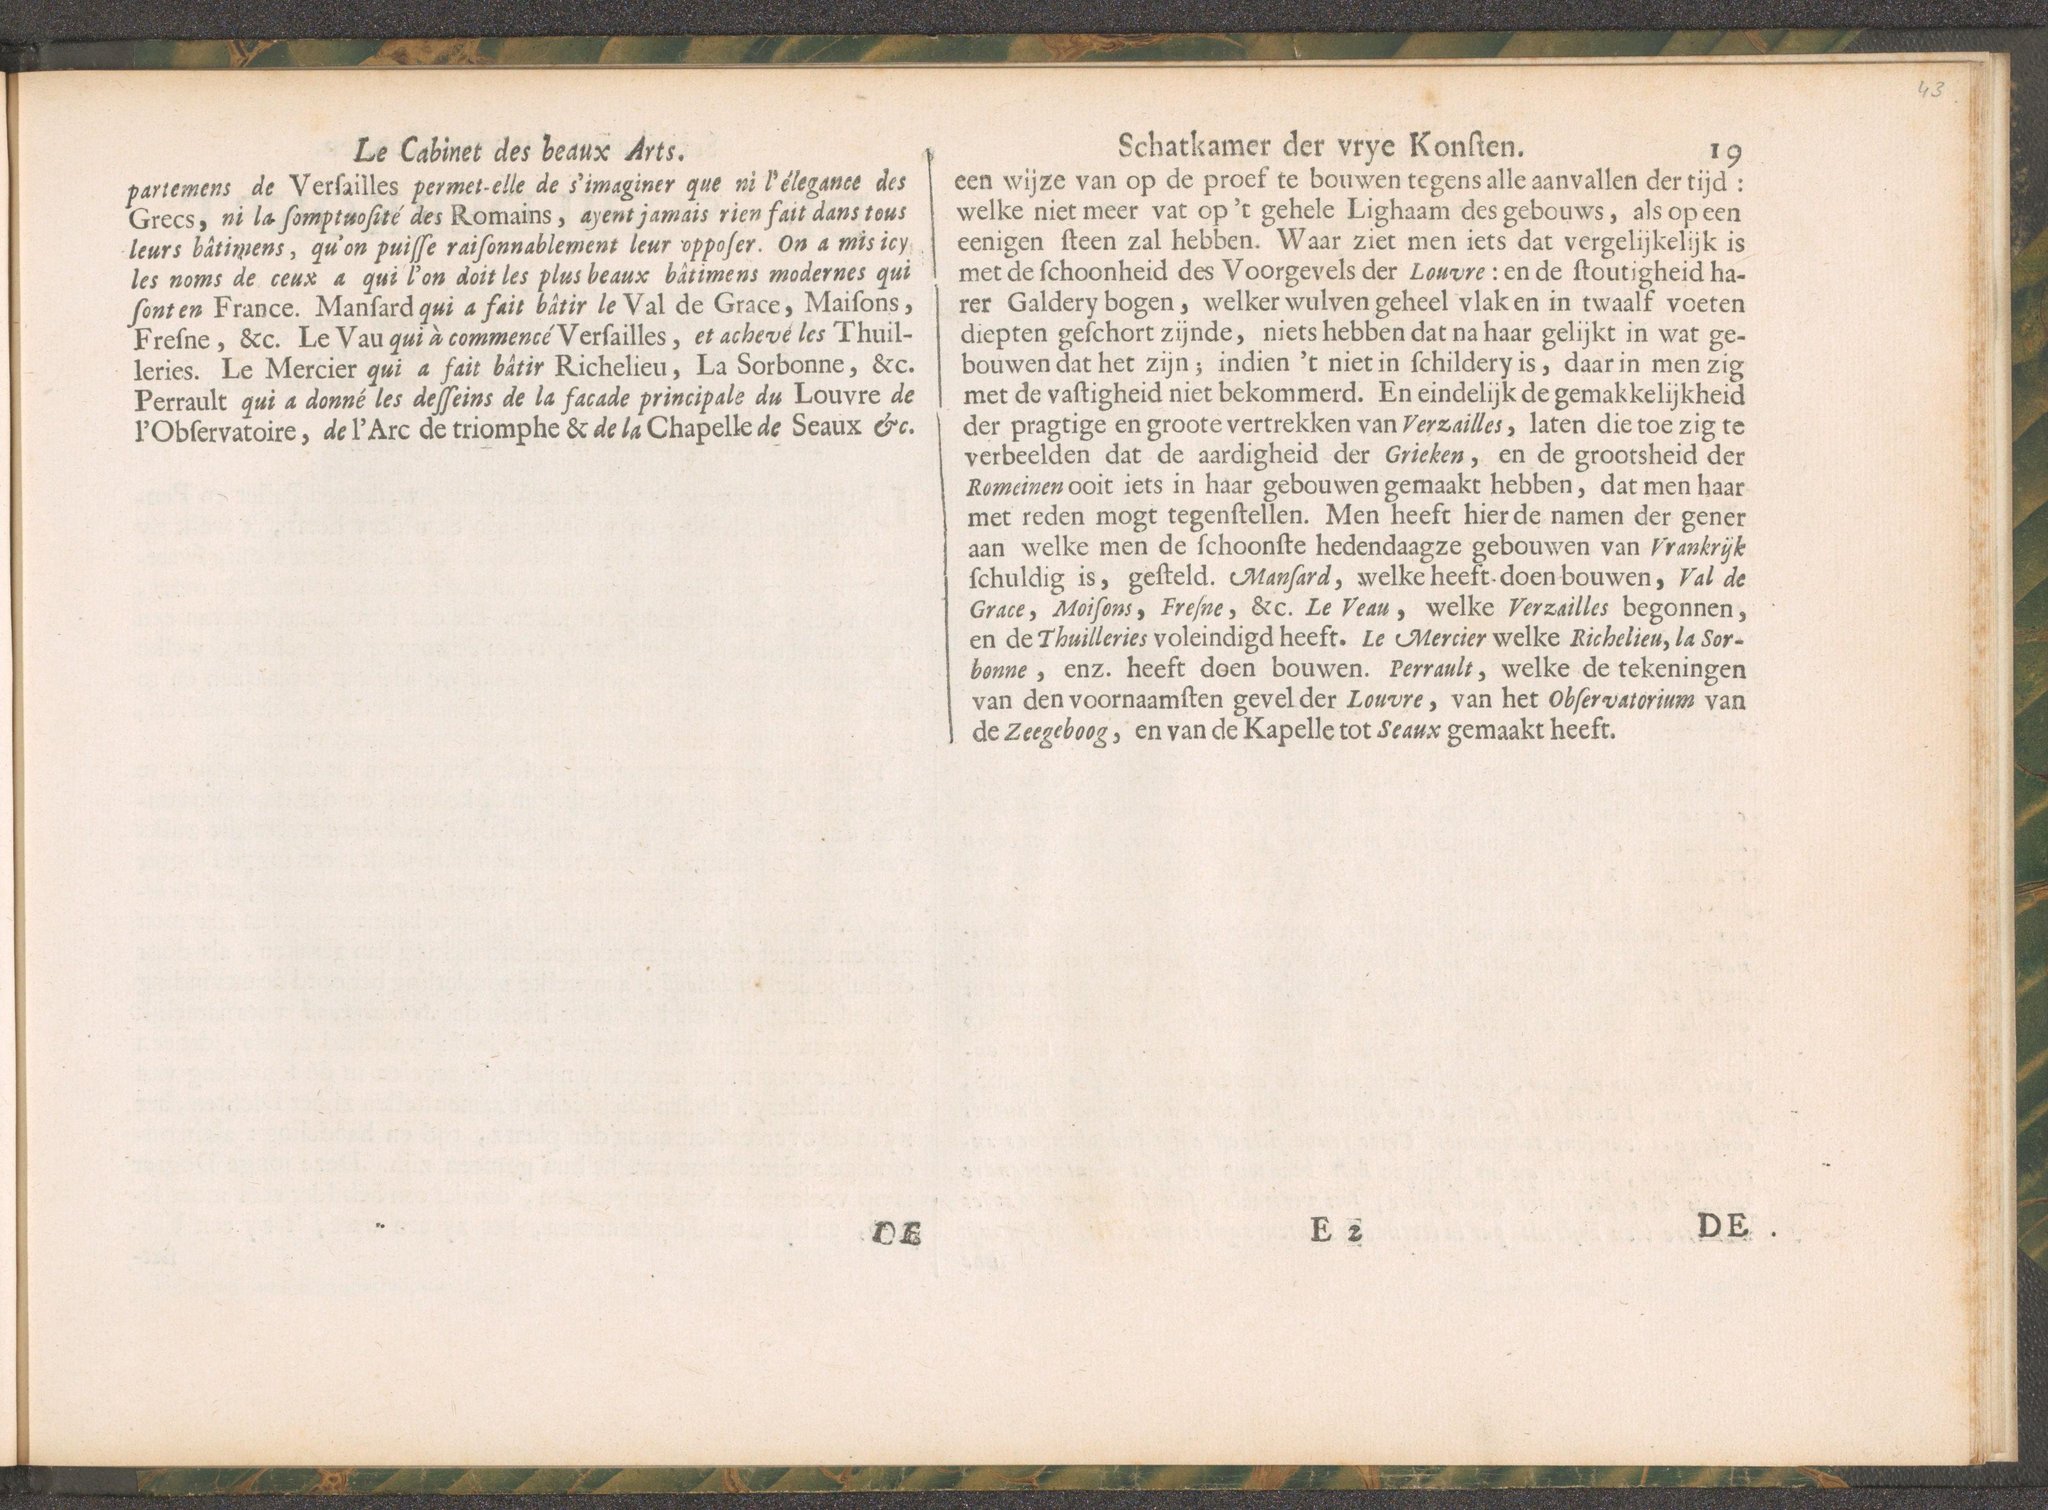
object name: text sheet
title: Tekstblad over de Architectuur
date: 1693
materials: paper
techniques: letterpress printing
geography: amsterdam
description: Verklaring van de prent met de voorstelling van de personificatie van Architectuur in het Frans en het Nederlands, pagina 19. Tekstblad maakt deel uit van een album.